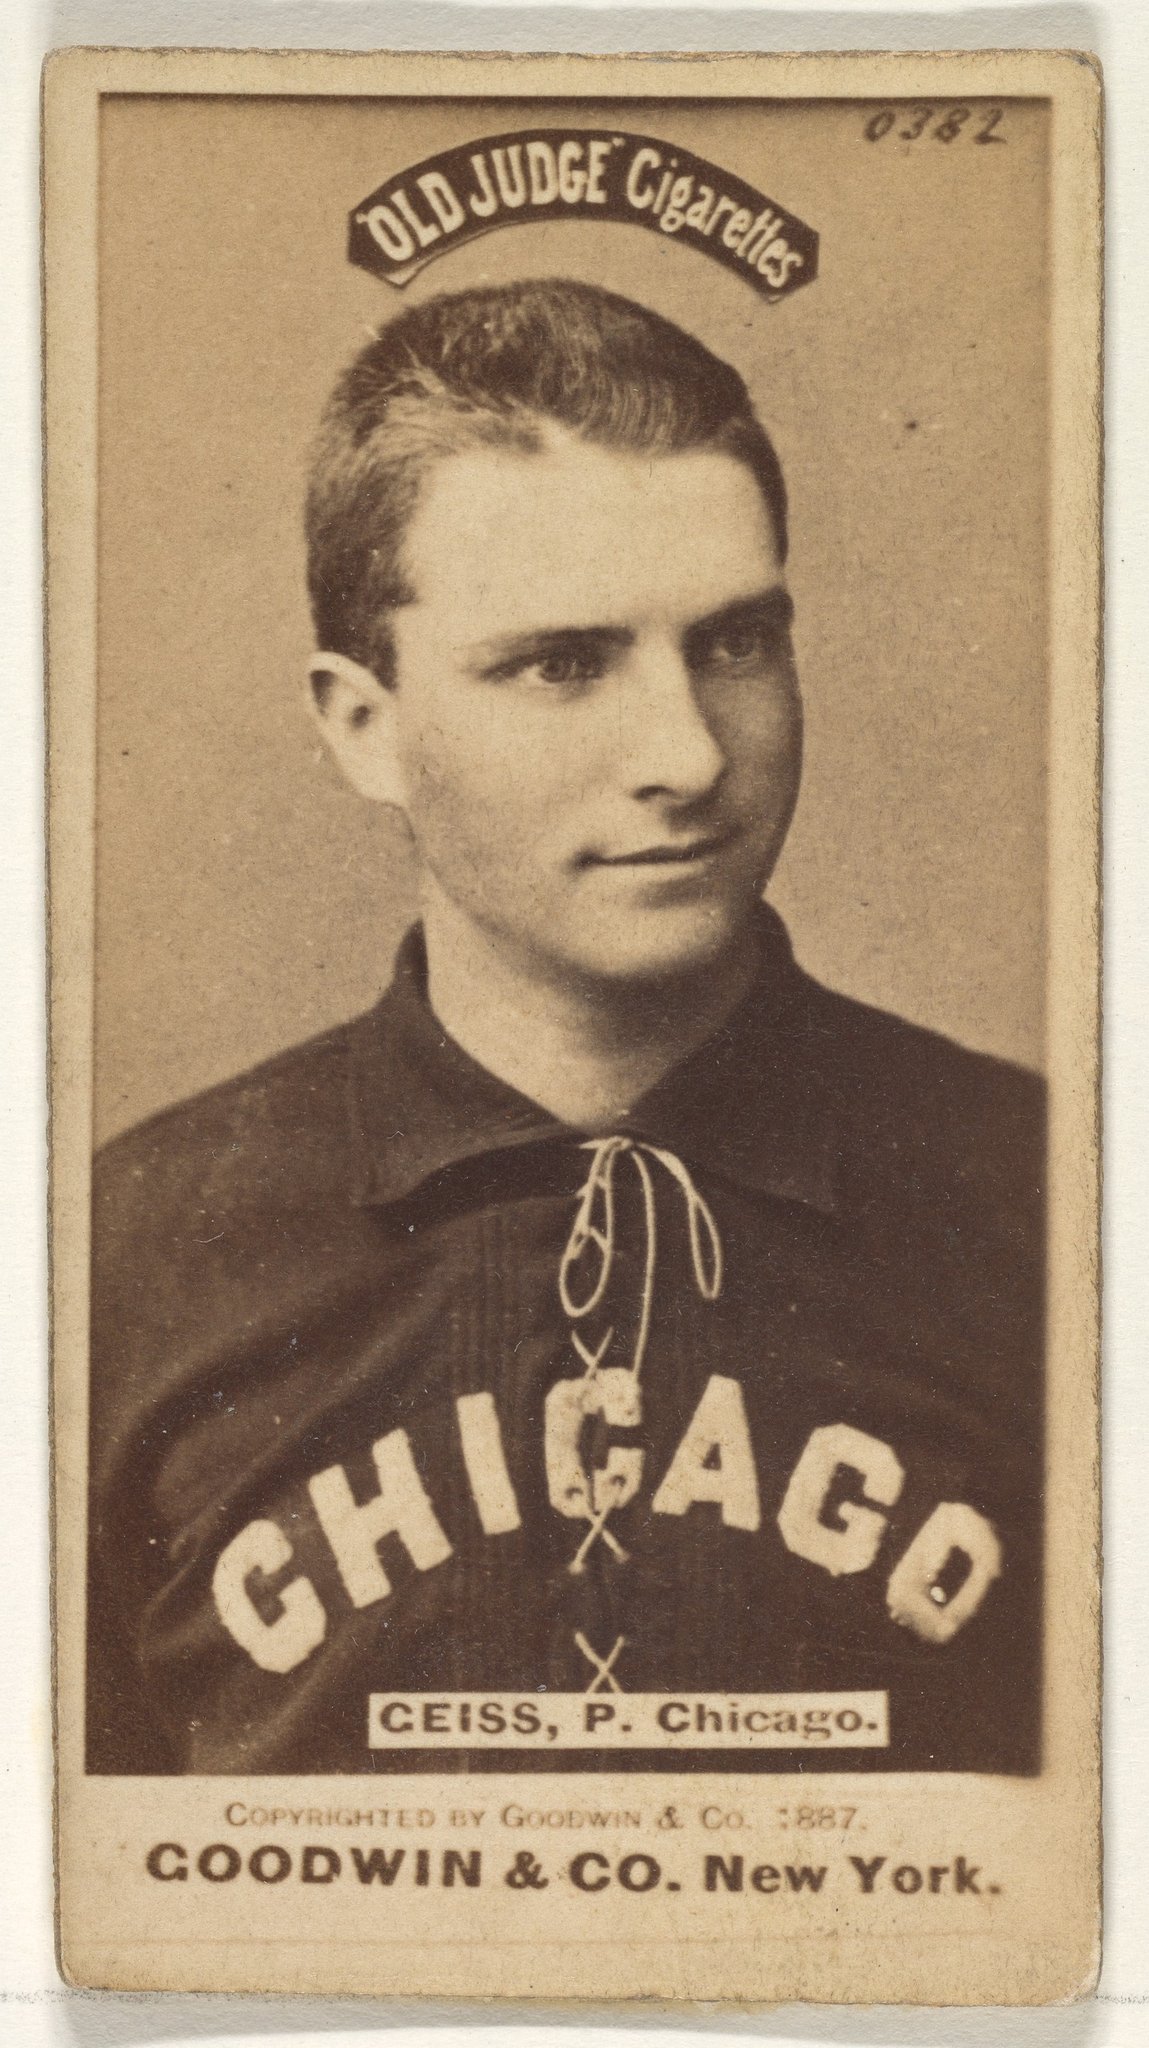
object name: baseball card, photograph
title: Ceiss, Pitcher, Chicago, from the Old Judge series (N172) for Old Judge Cigarettes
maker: goodwin & company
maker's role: publisher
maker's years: 1850-1950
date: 1887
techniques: albumen silver print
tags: men,portraits,baseball,athletes